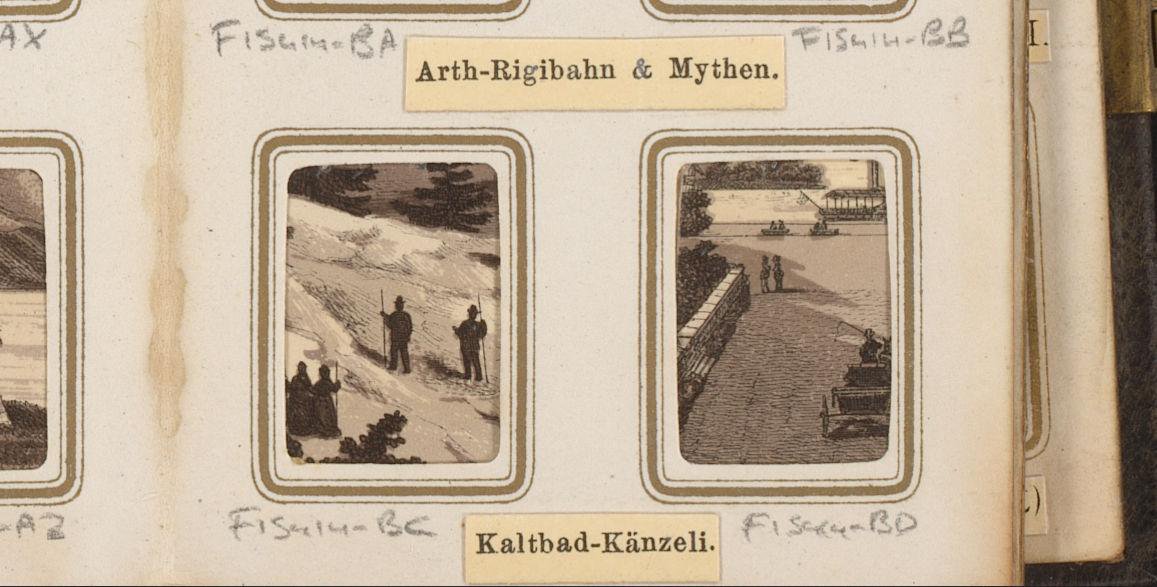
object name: album leaf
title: Wandelaars nabij Rigi Kaltbad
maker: Anonymous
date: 1851-1910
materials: paper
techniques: lithograph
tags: walking, hiking (recreation)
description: Deze prent maakt deel uit van een album.